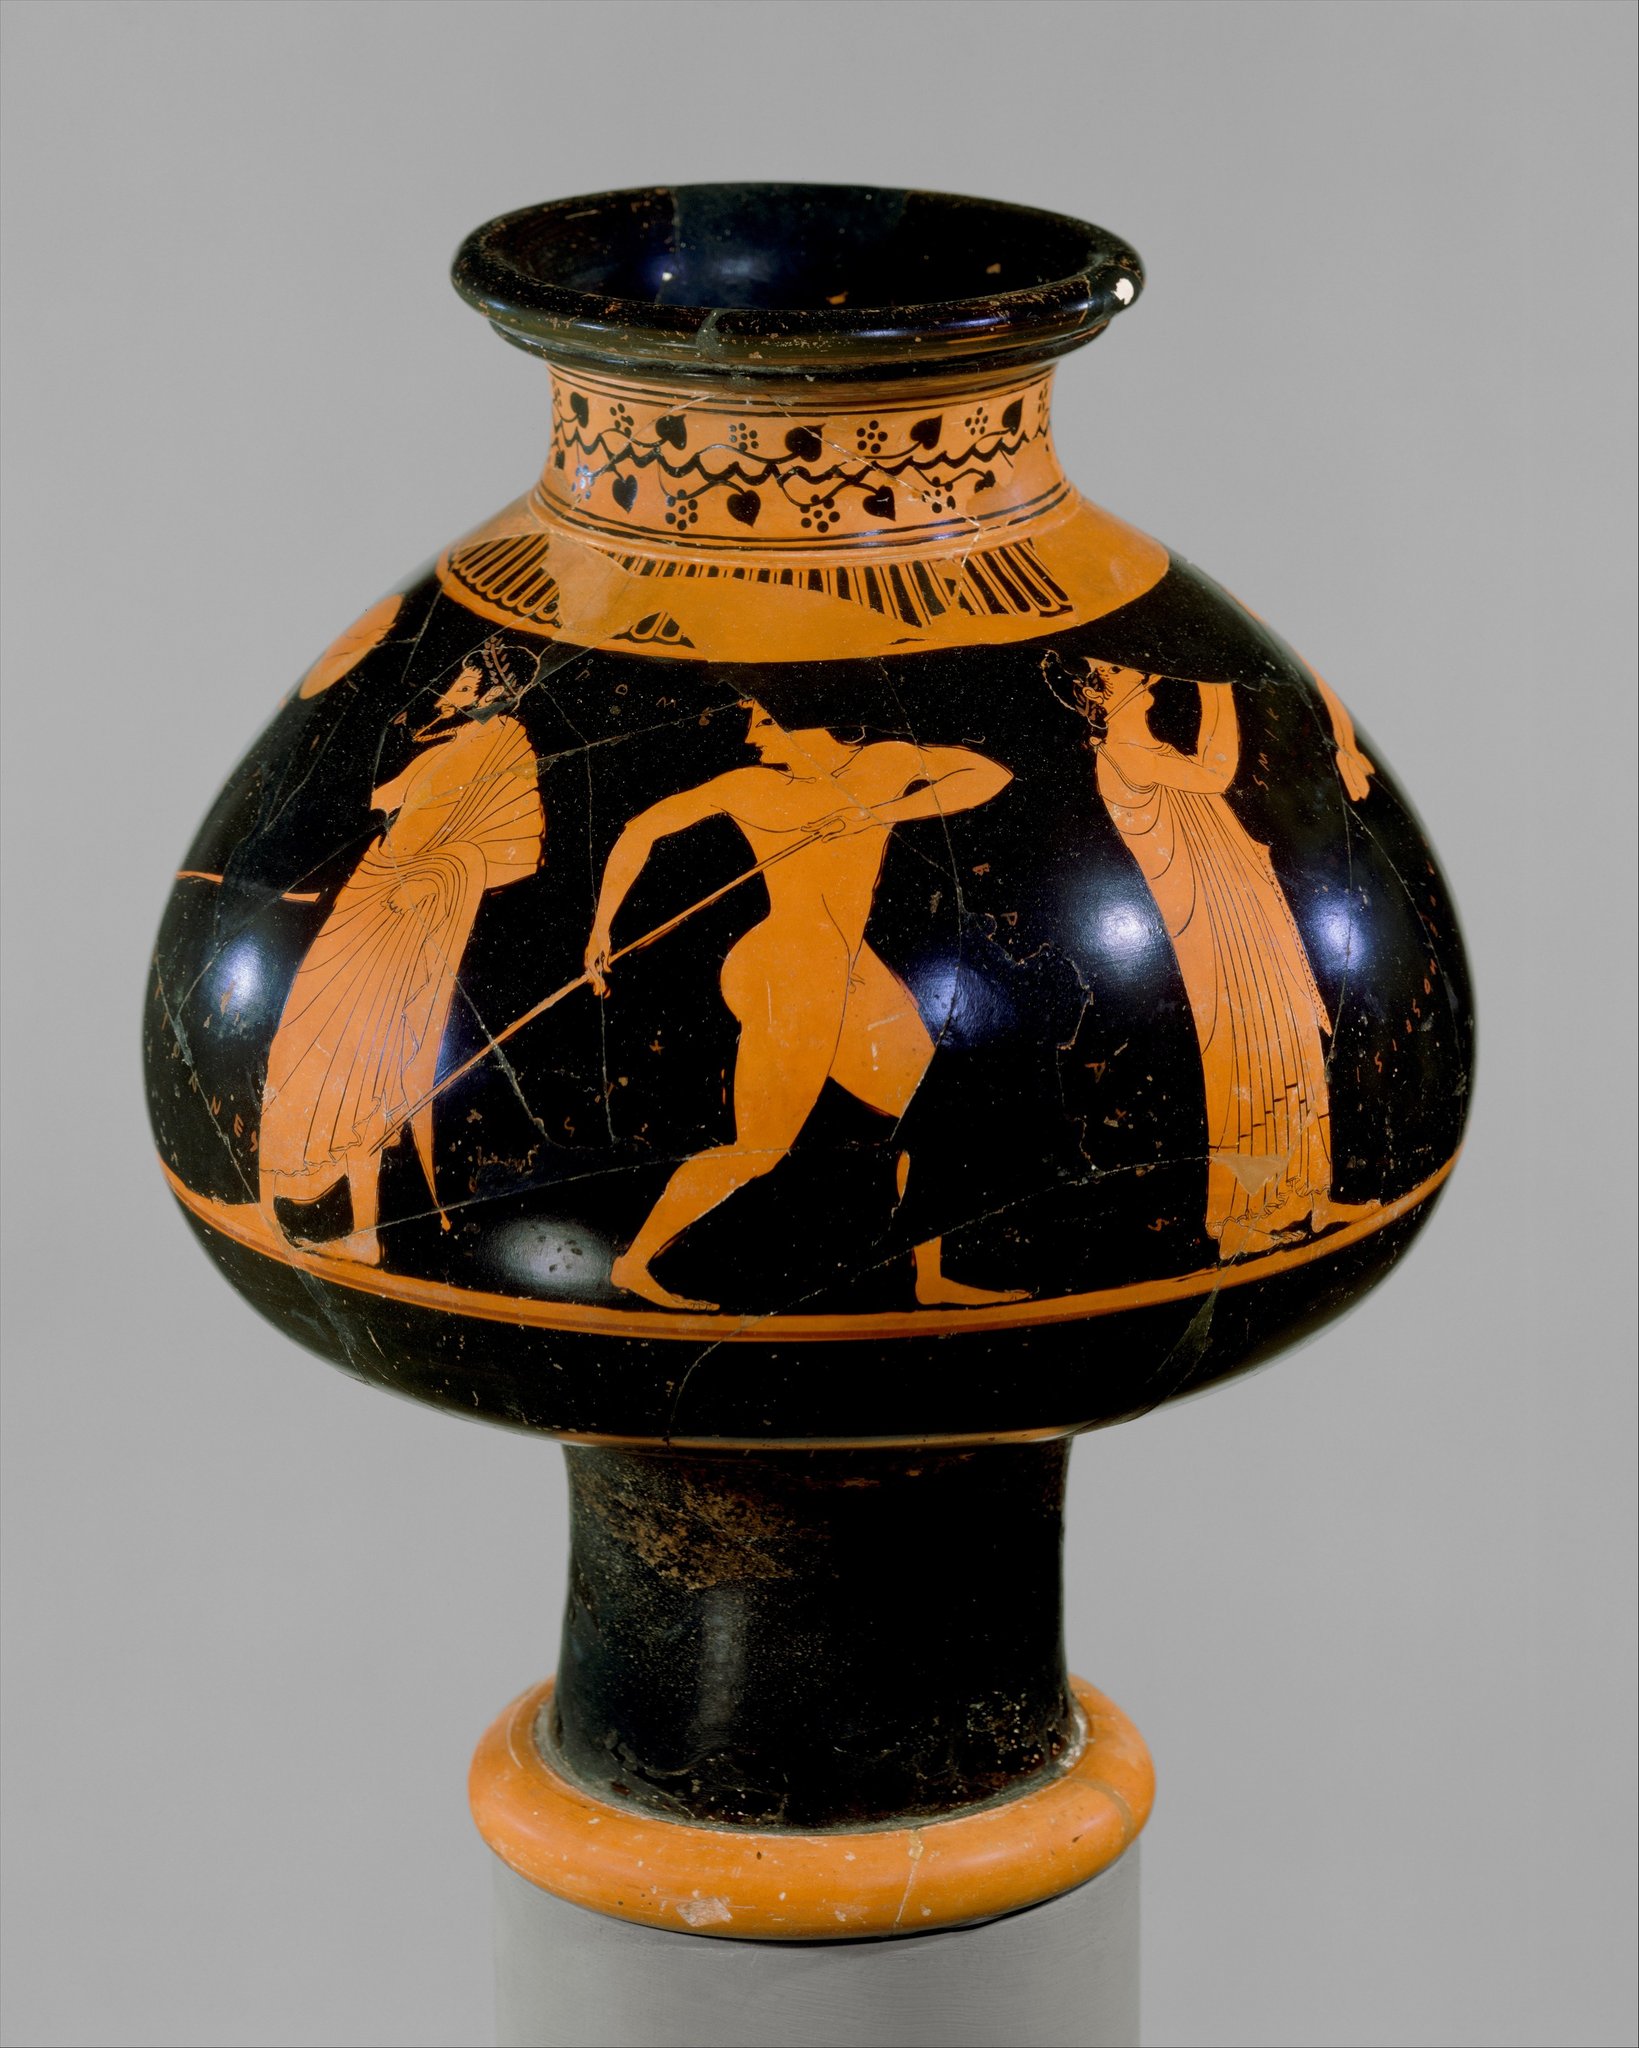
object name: psykter fragment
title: Psykter fragments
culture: greek, attic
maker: oltos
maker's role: artist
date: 520-510 BCE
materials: terracotta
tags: men,male nudes